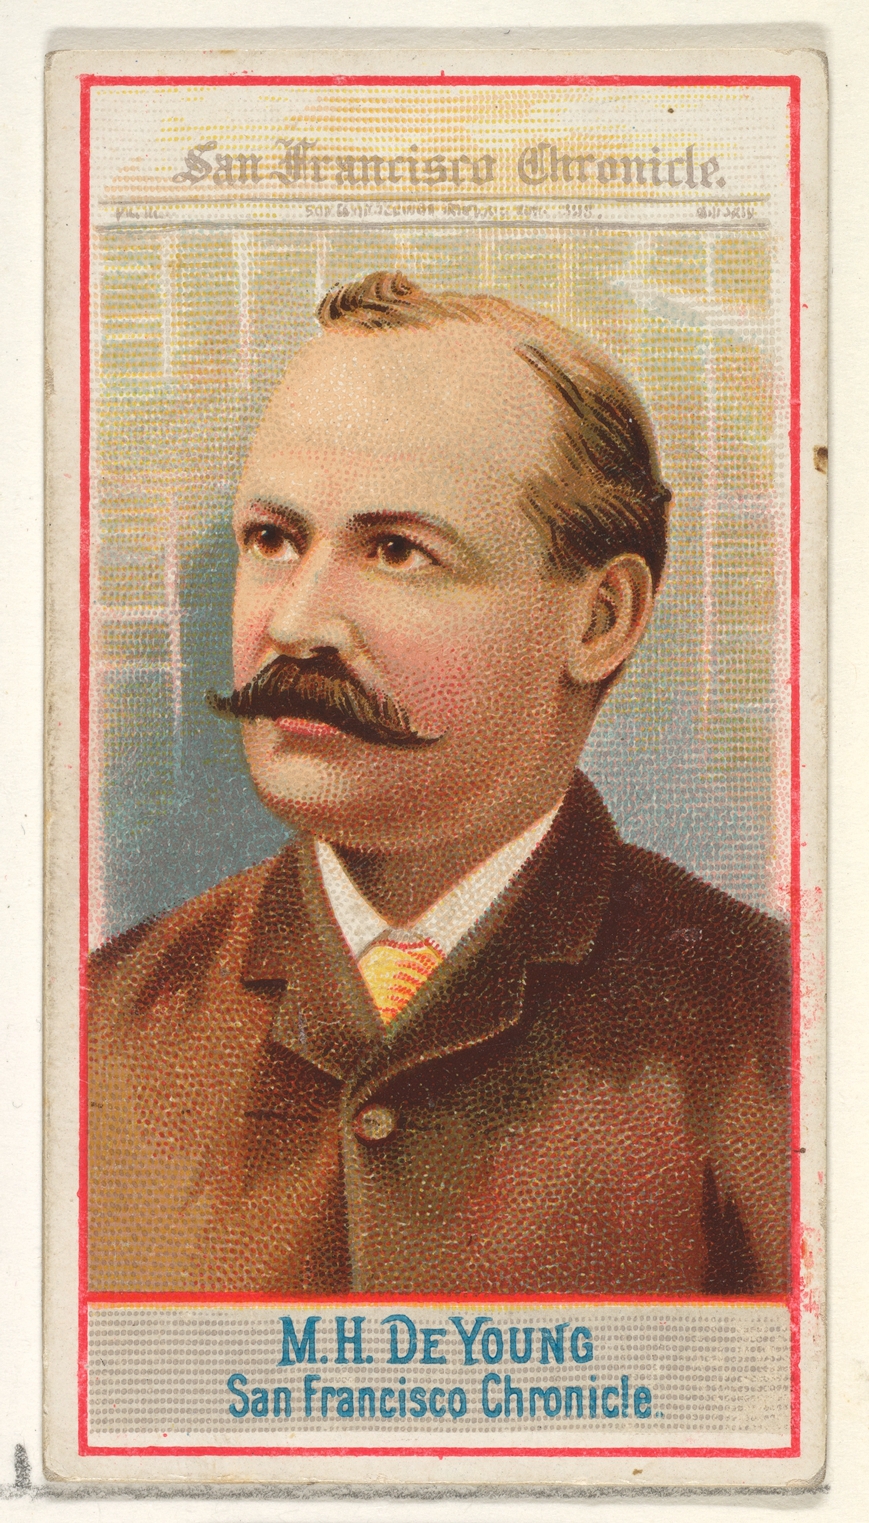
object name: print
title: M.H. de Young, San Francisco Chronicle, from the American Editors series (N1) for Allen & Ginter Cigarettes Brands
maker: allen & ginter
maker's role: publisher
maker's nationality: american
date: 1887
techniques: color lithograph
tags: men,portraits